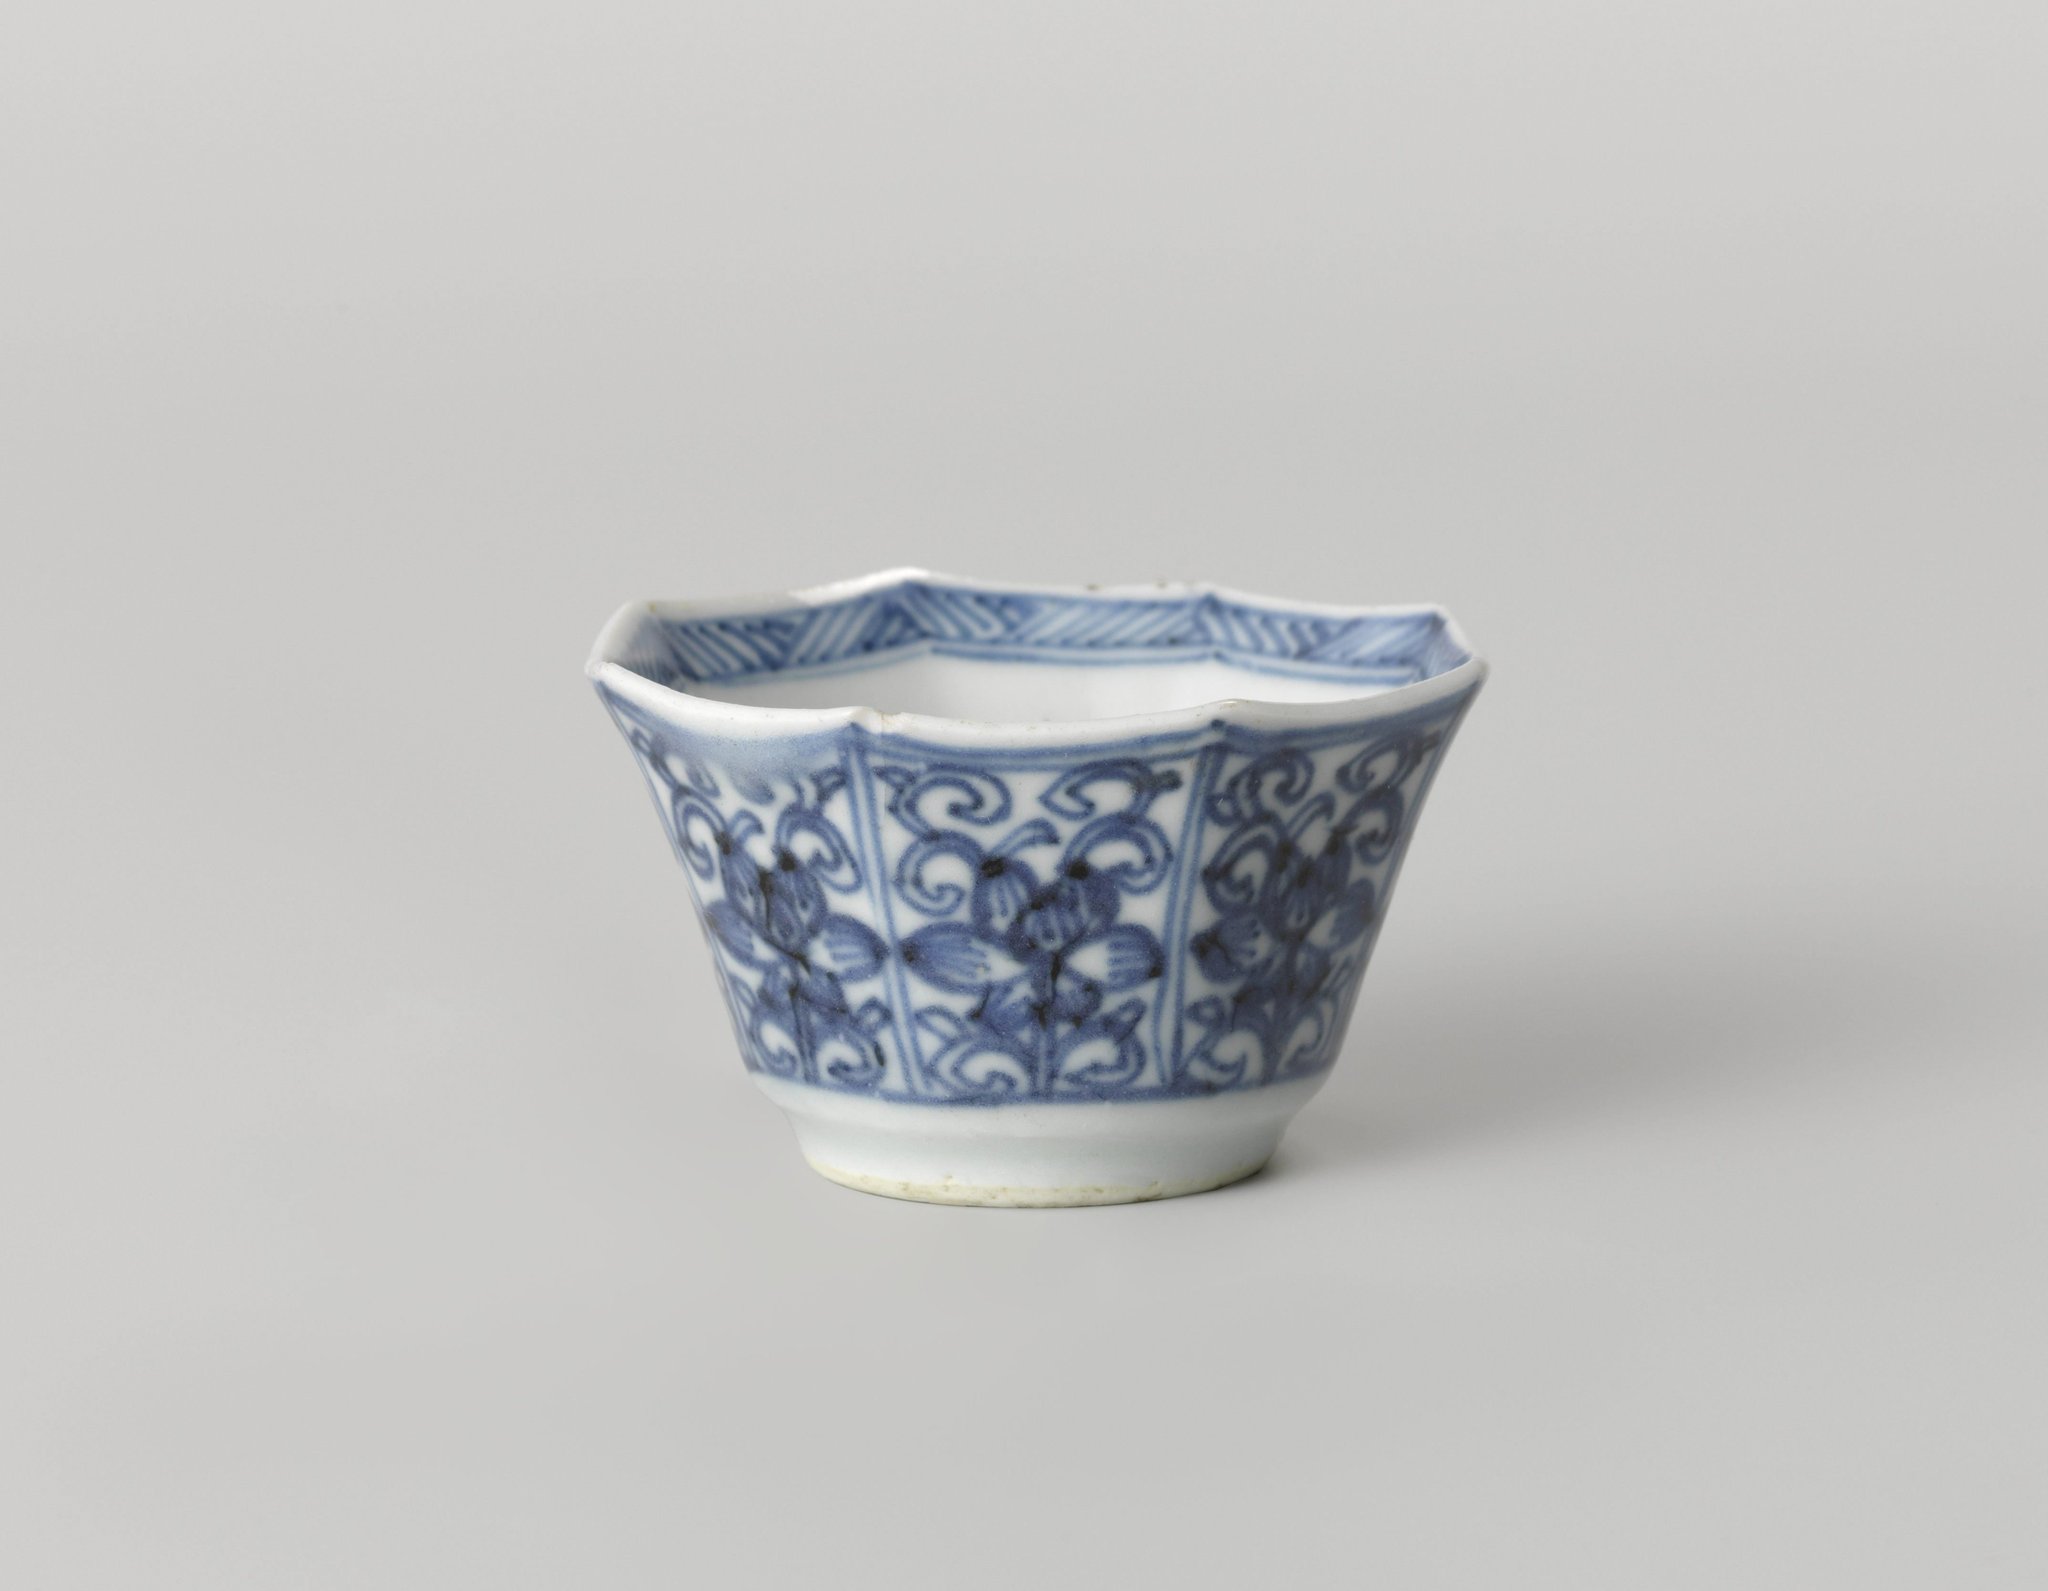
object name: cup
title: Octagonal cup with flower scrolls in panel decoration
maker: Anonymous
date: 1700-1724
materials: cobalt, glaze, paint, porcelain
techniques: firing, forming, turning, vitrification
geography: china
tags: ornament derived from plant forms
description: Kop van porselein, achtkantig, zonder oor. Beschilderd in onderglazuurblauw met een symmetrisch decor van een bloem en voluuttakken, dat zich op elk vak herhaalt. Langs de binnenzijde van de mondrand een geometrische lijst van schuine lijnen. Op de bodem een achthoek, waarin een bloem.